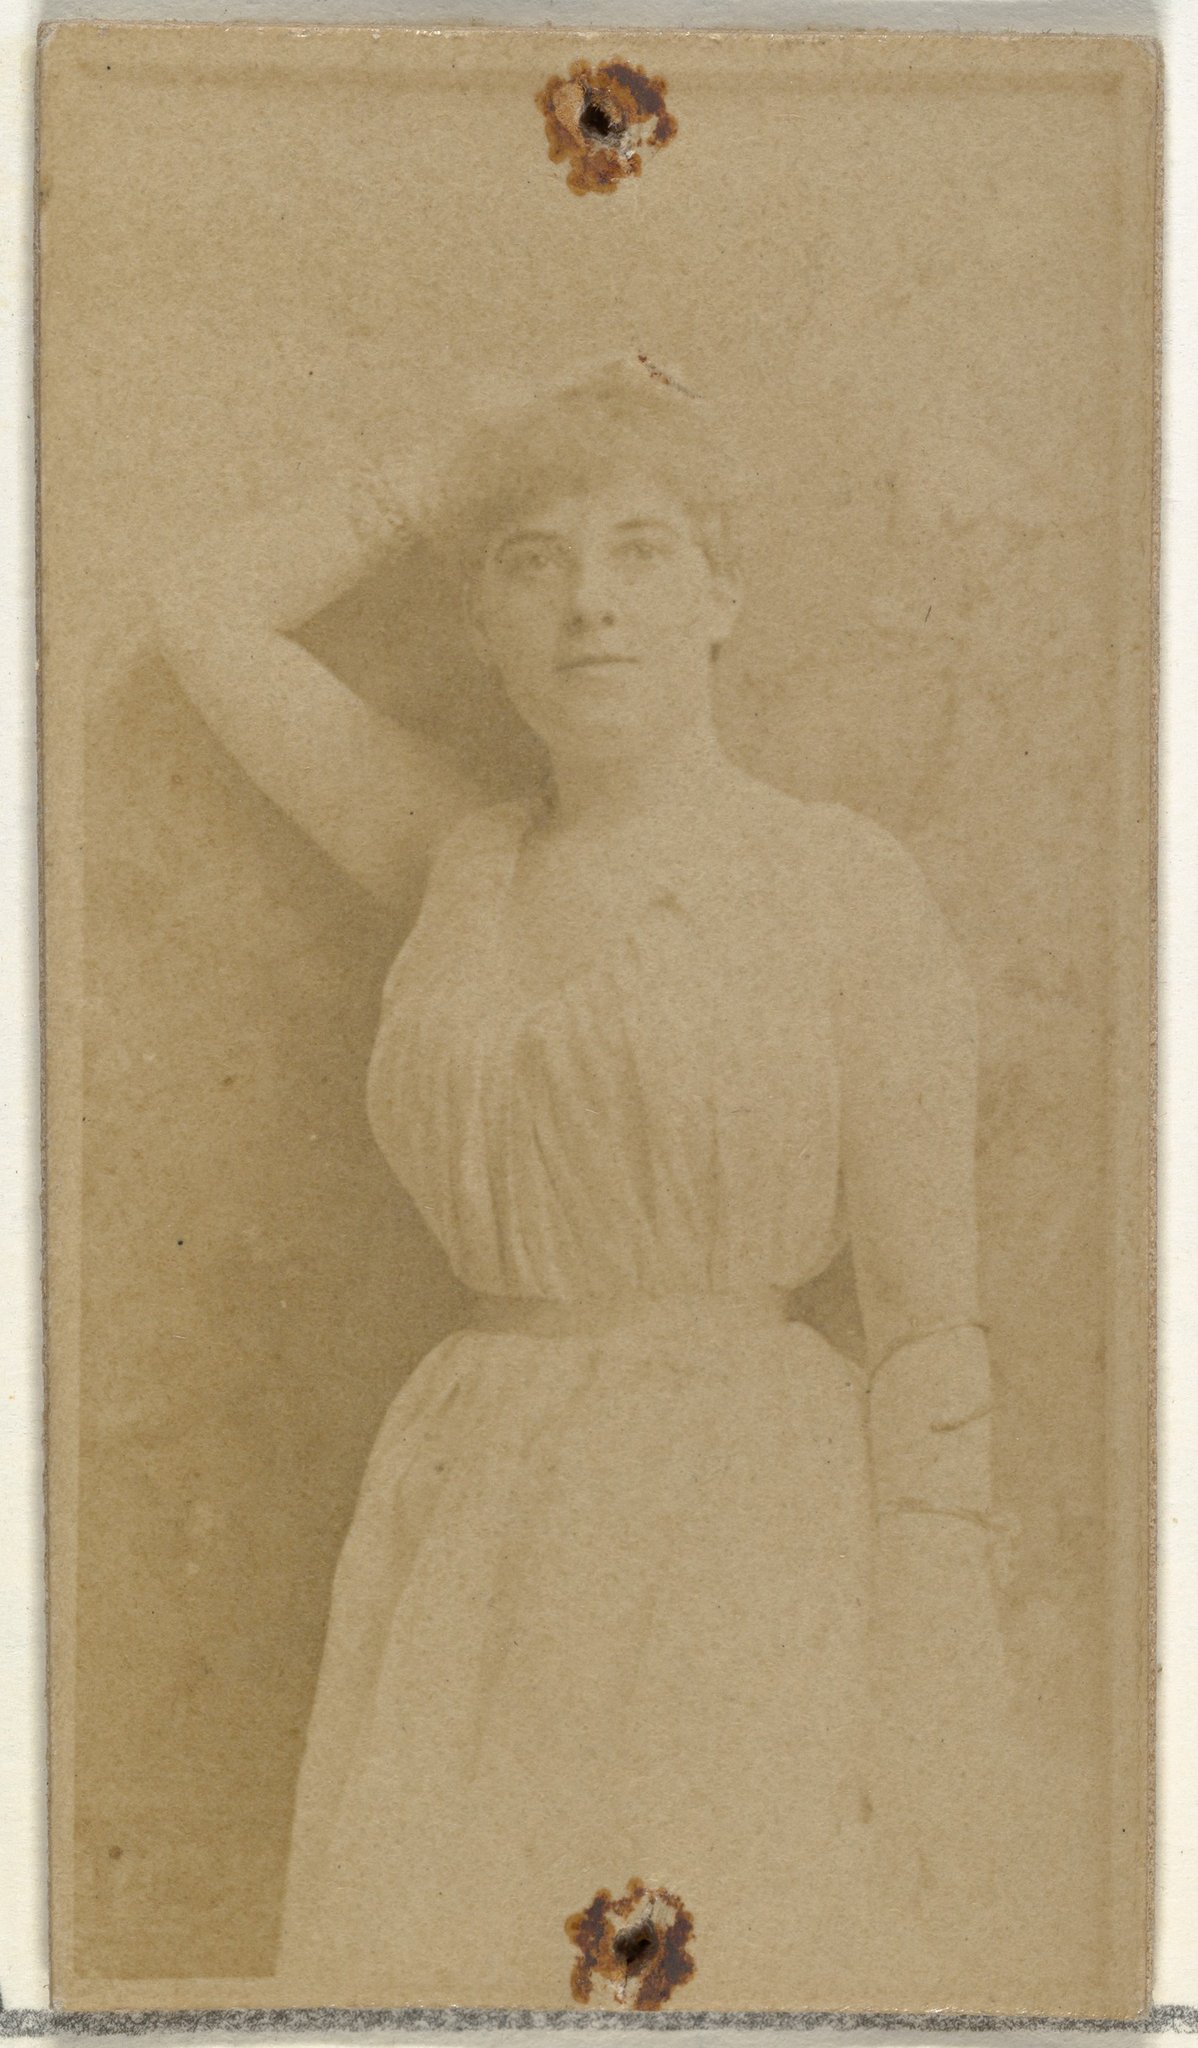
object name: photograph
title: [Actress posing with hand over head], from the Actors and Actresses series (N145-8) issued by Duke Sons & Co. to promote Duke Cigarettes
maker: w. duke, sons & co.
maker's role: publisher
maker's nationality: american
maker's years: 1870-1920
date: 1891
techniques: albumen silver print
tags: portraits,women,actresses